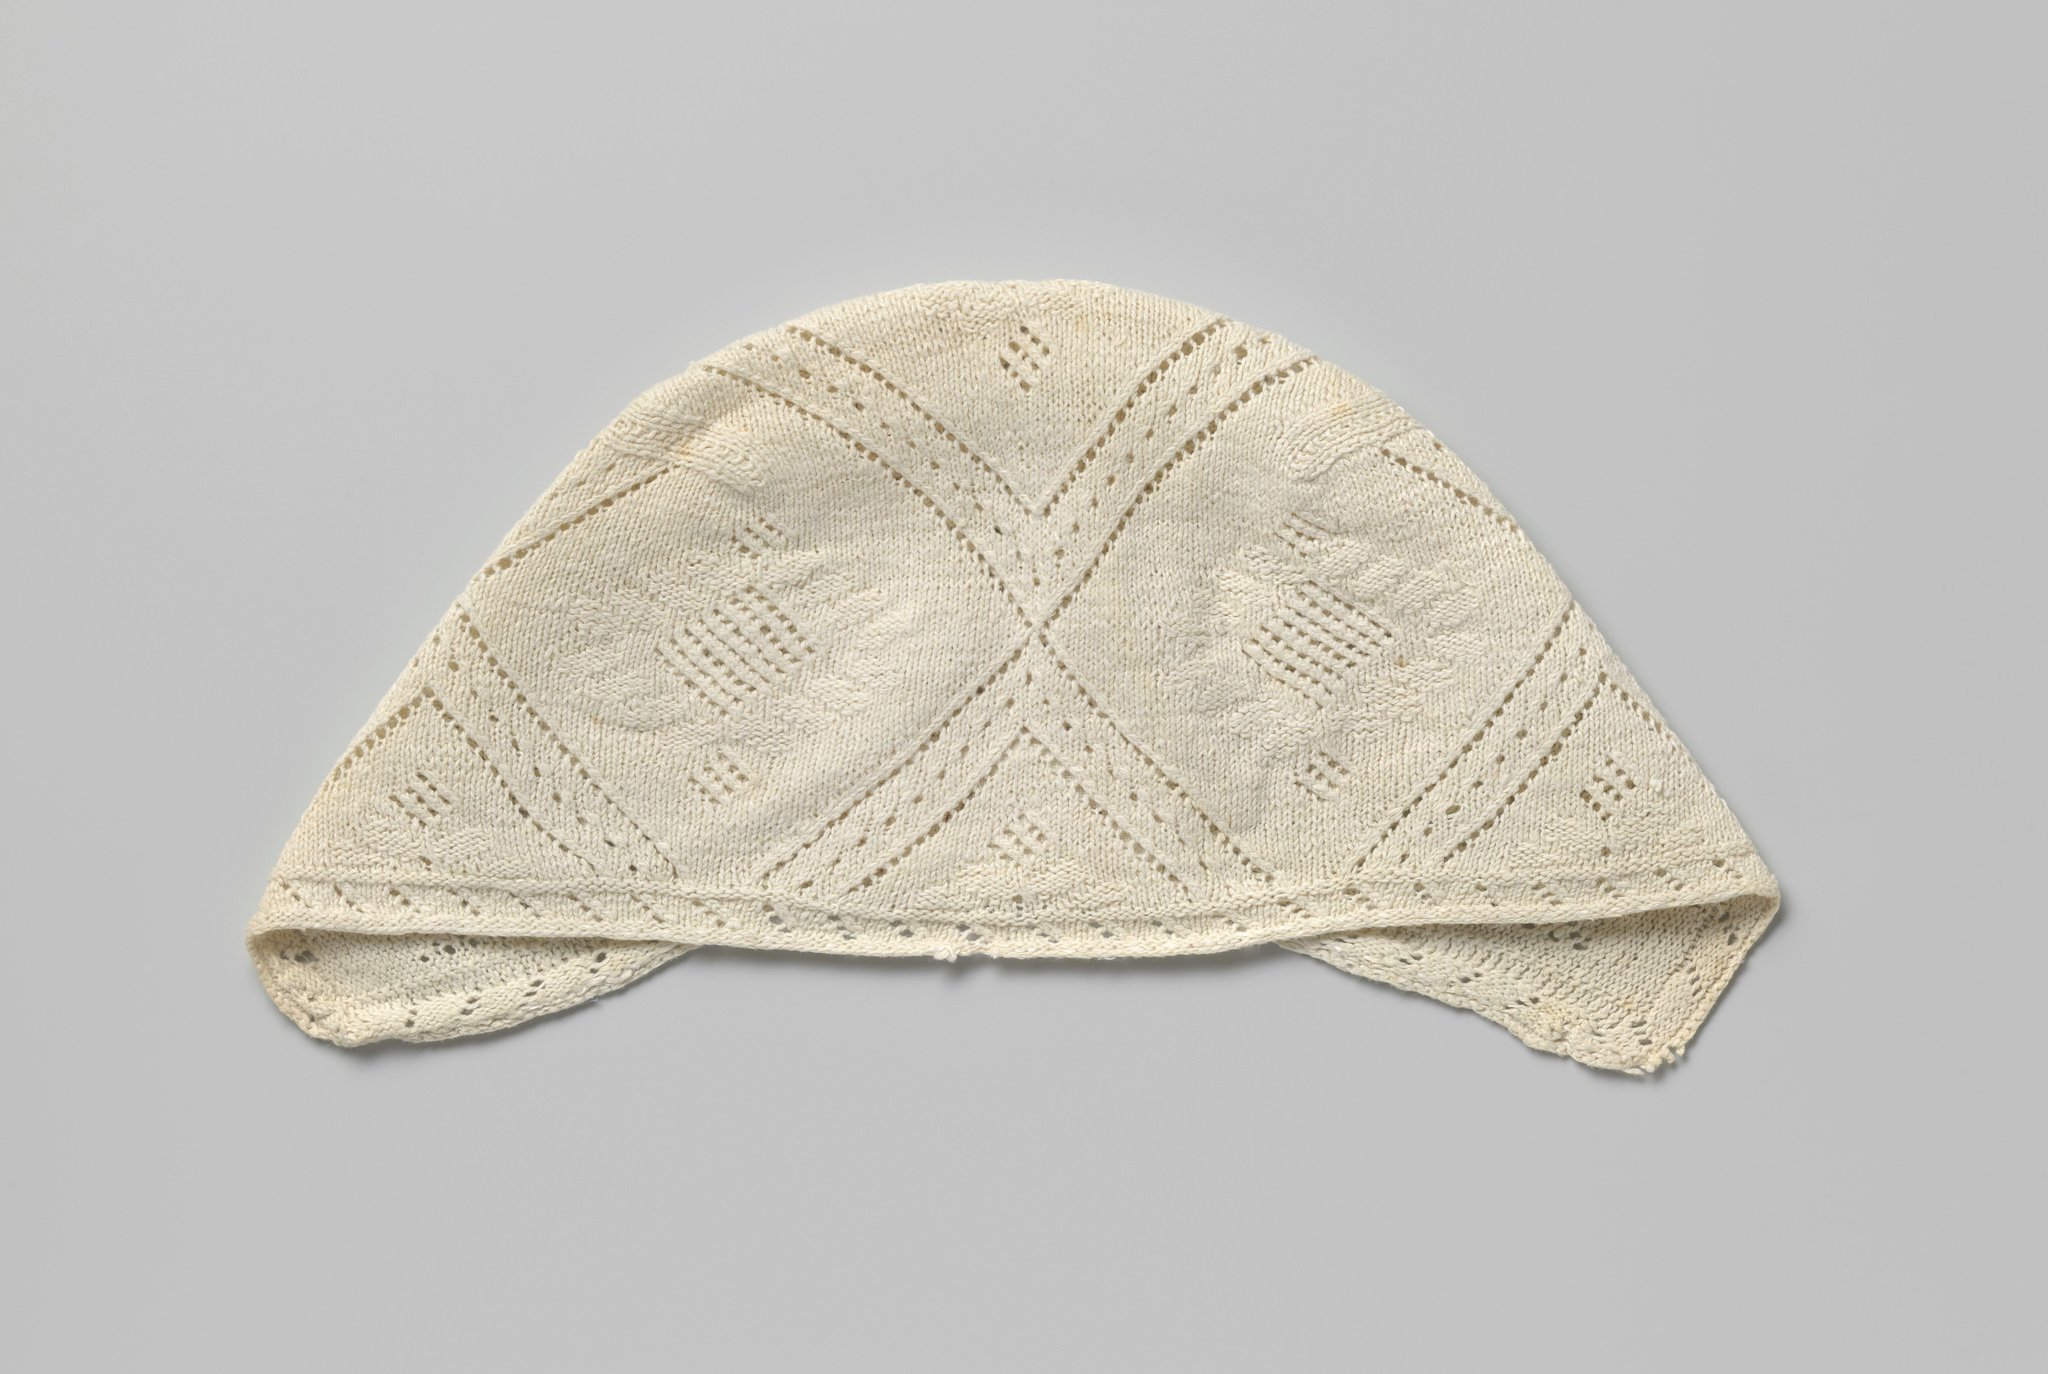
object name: womenswear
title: Gebreide muts van wit katoen met opengewerkte zigzagranden en een motief met rasterwerk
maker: Anonymous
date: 1800-1900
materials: cotton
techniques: embroidery, knitting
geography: europe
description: Gebreide muts van wit katoen met opengewerkte zigzagranden en een motief met rasterwerk.